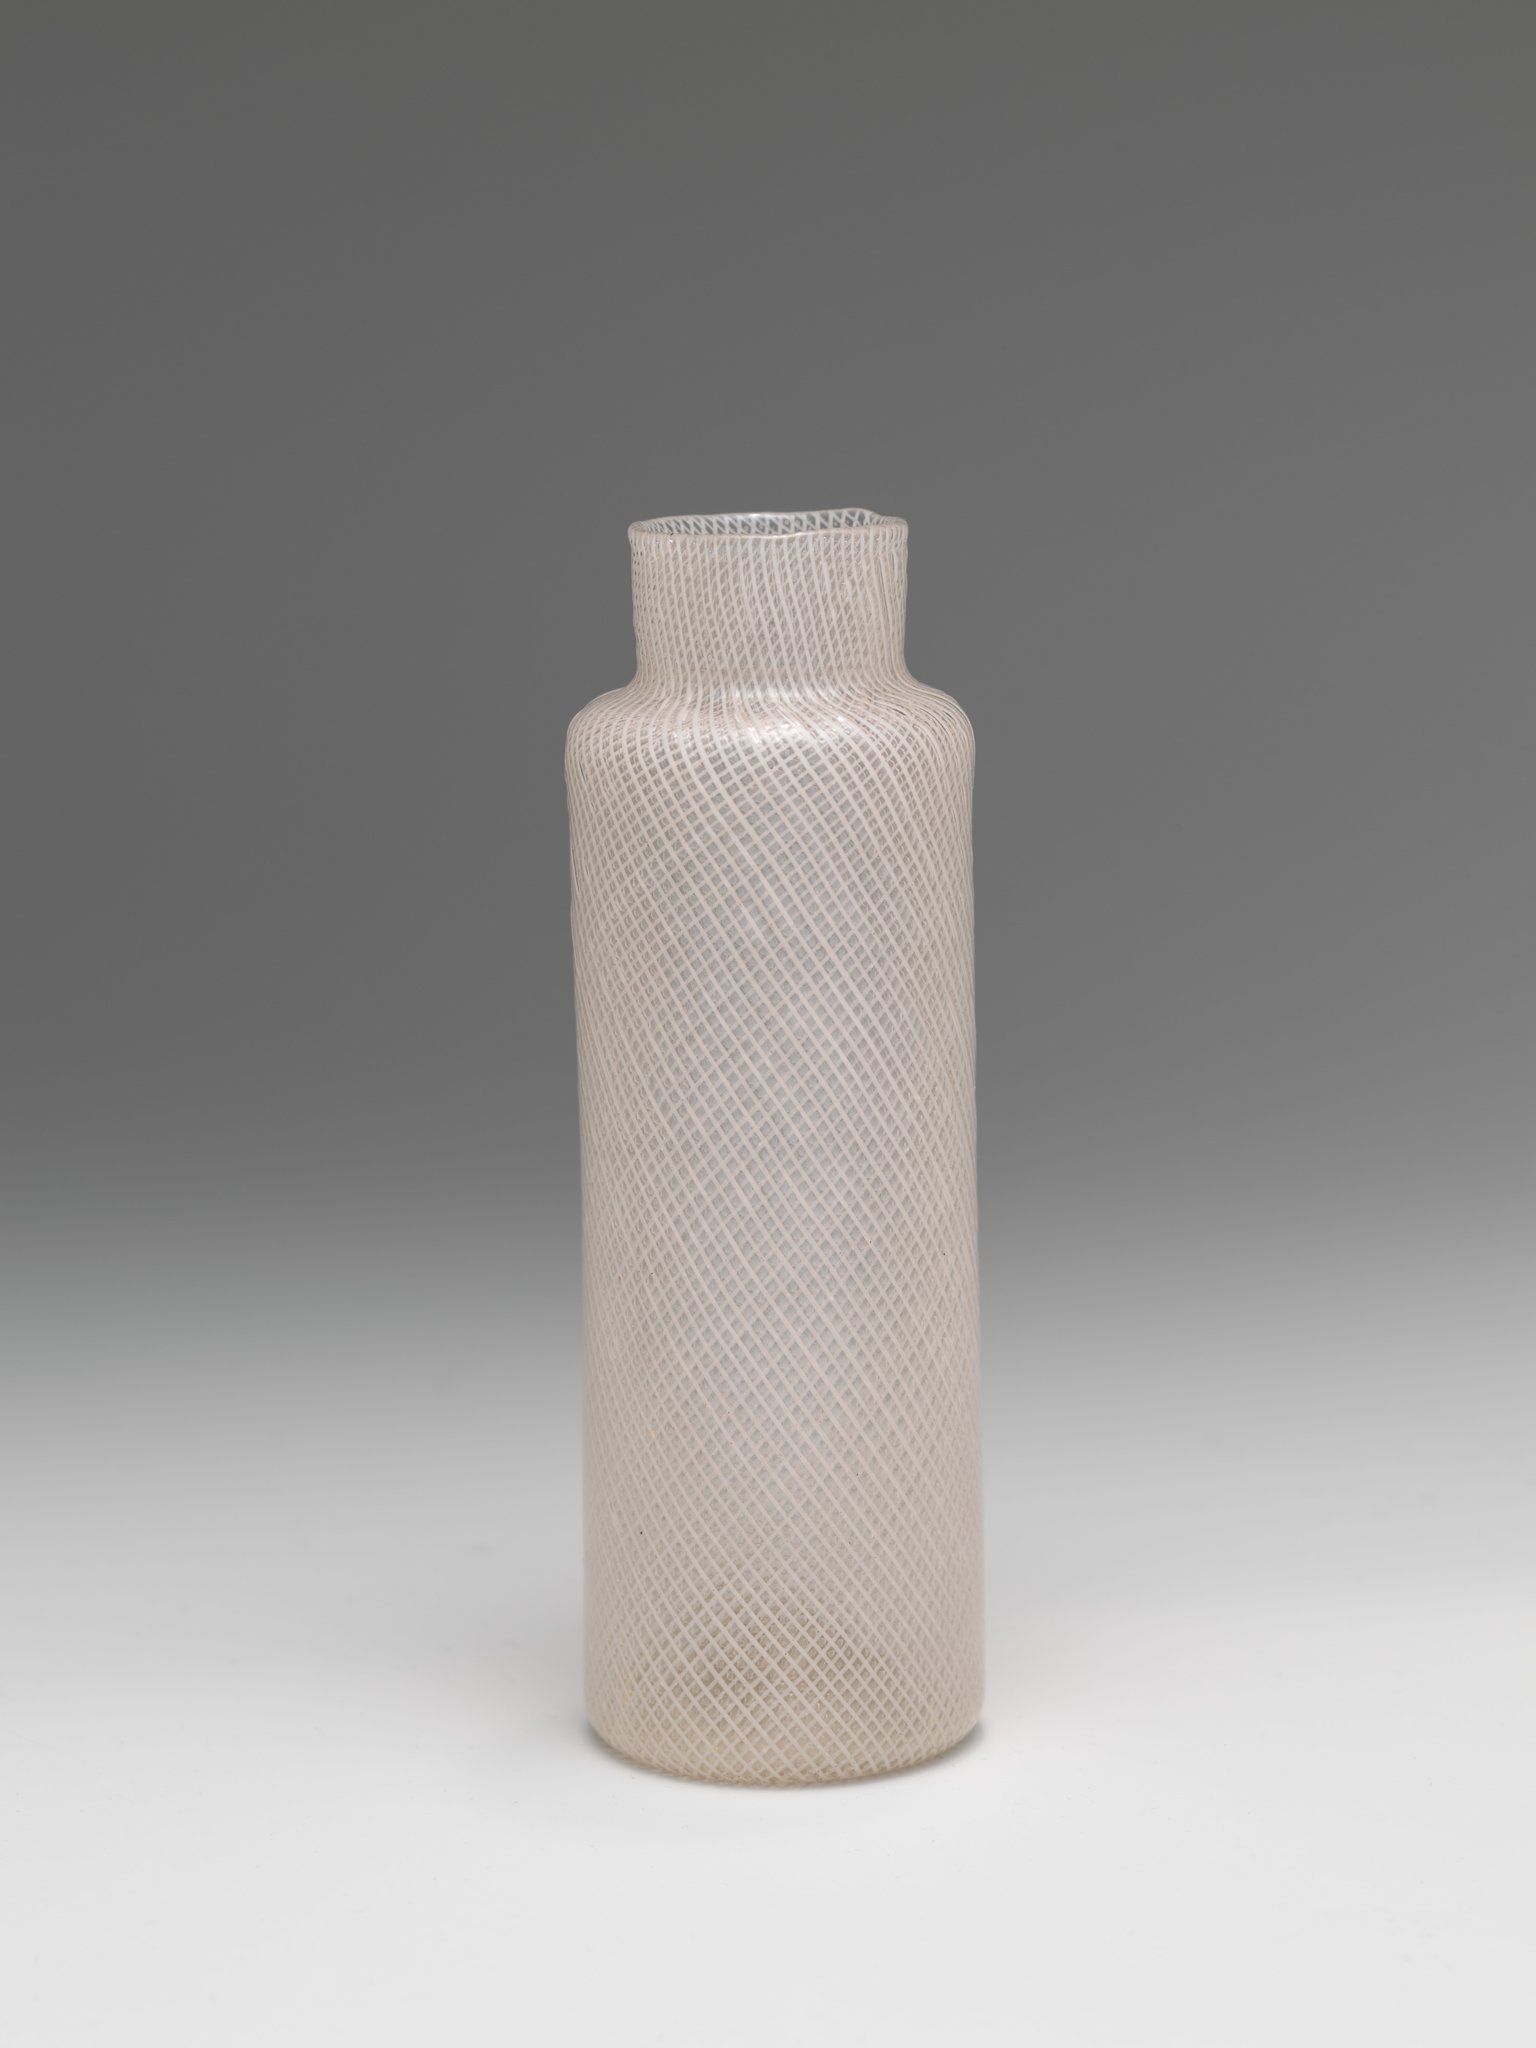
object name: bottle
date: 1601-1800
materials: glass